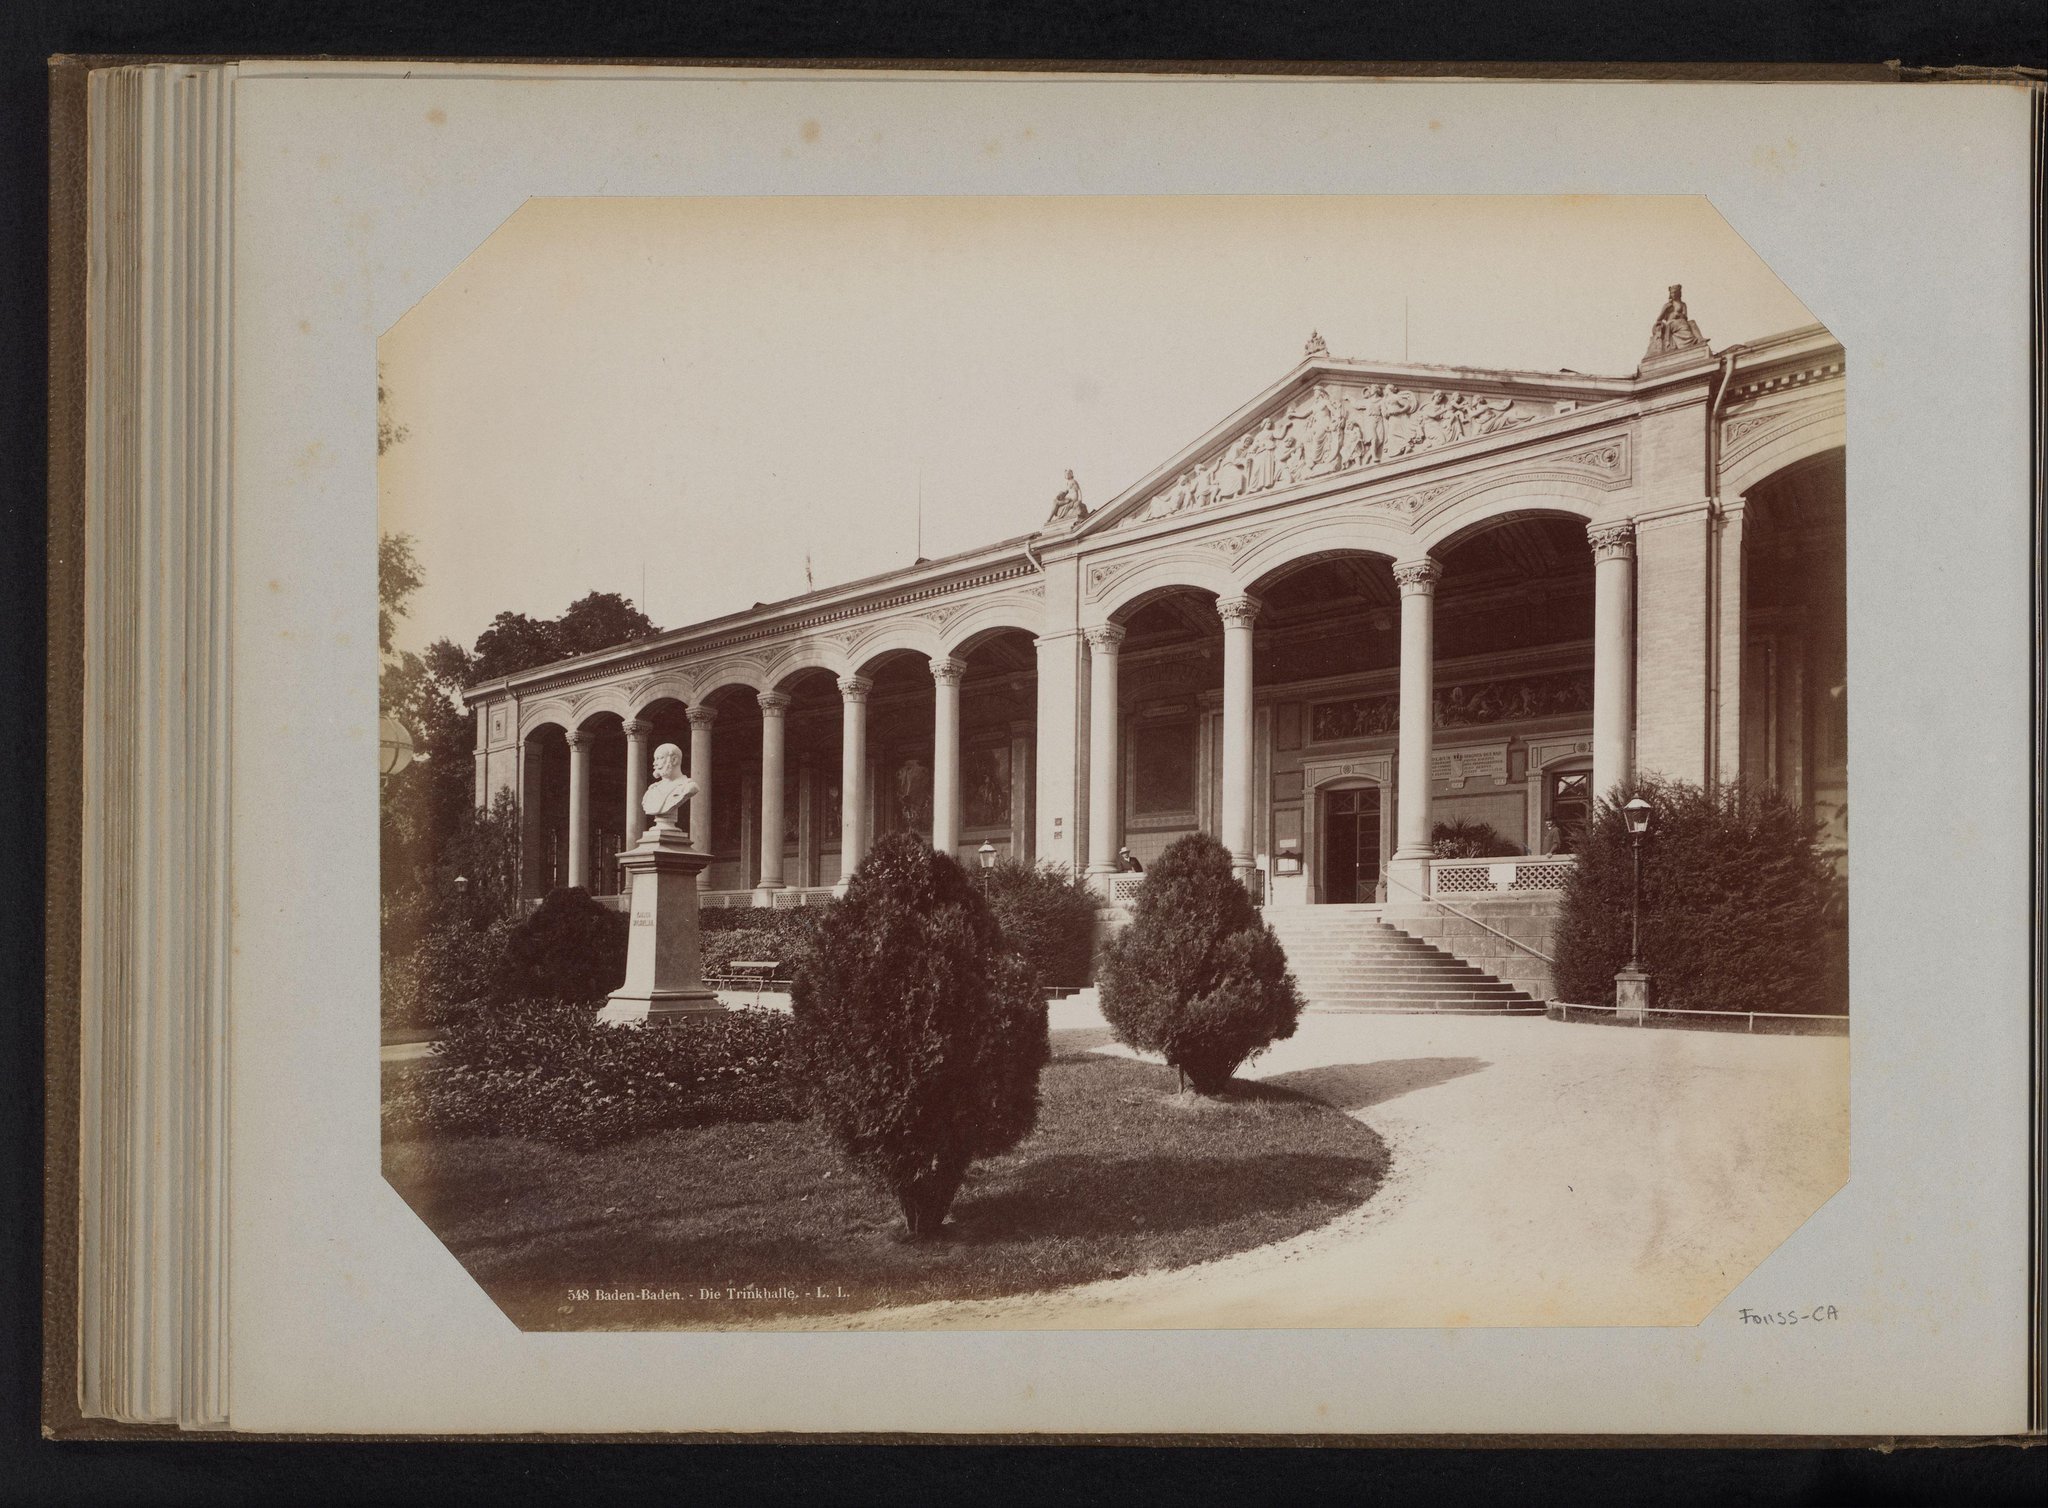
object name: album leaf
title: Gezicht op de Trinkhalle te Baden-Baden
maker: ll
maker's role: fotograaf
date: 1890-1899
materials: photographic support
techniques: albumen print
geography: baden-baden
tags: watering-place, spa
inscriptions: inscription: ‘548 Baden-Baden. - Die Trinkhalle - L.L.’